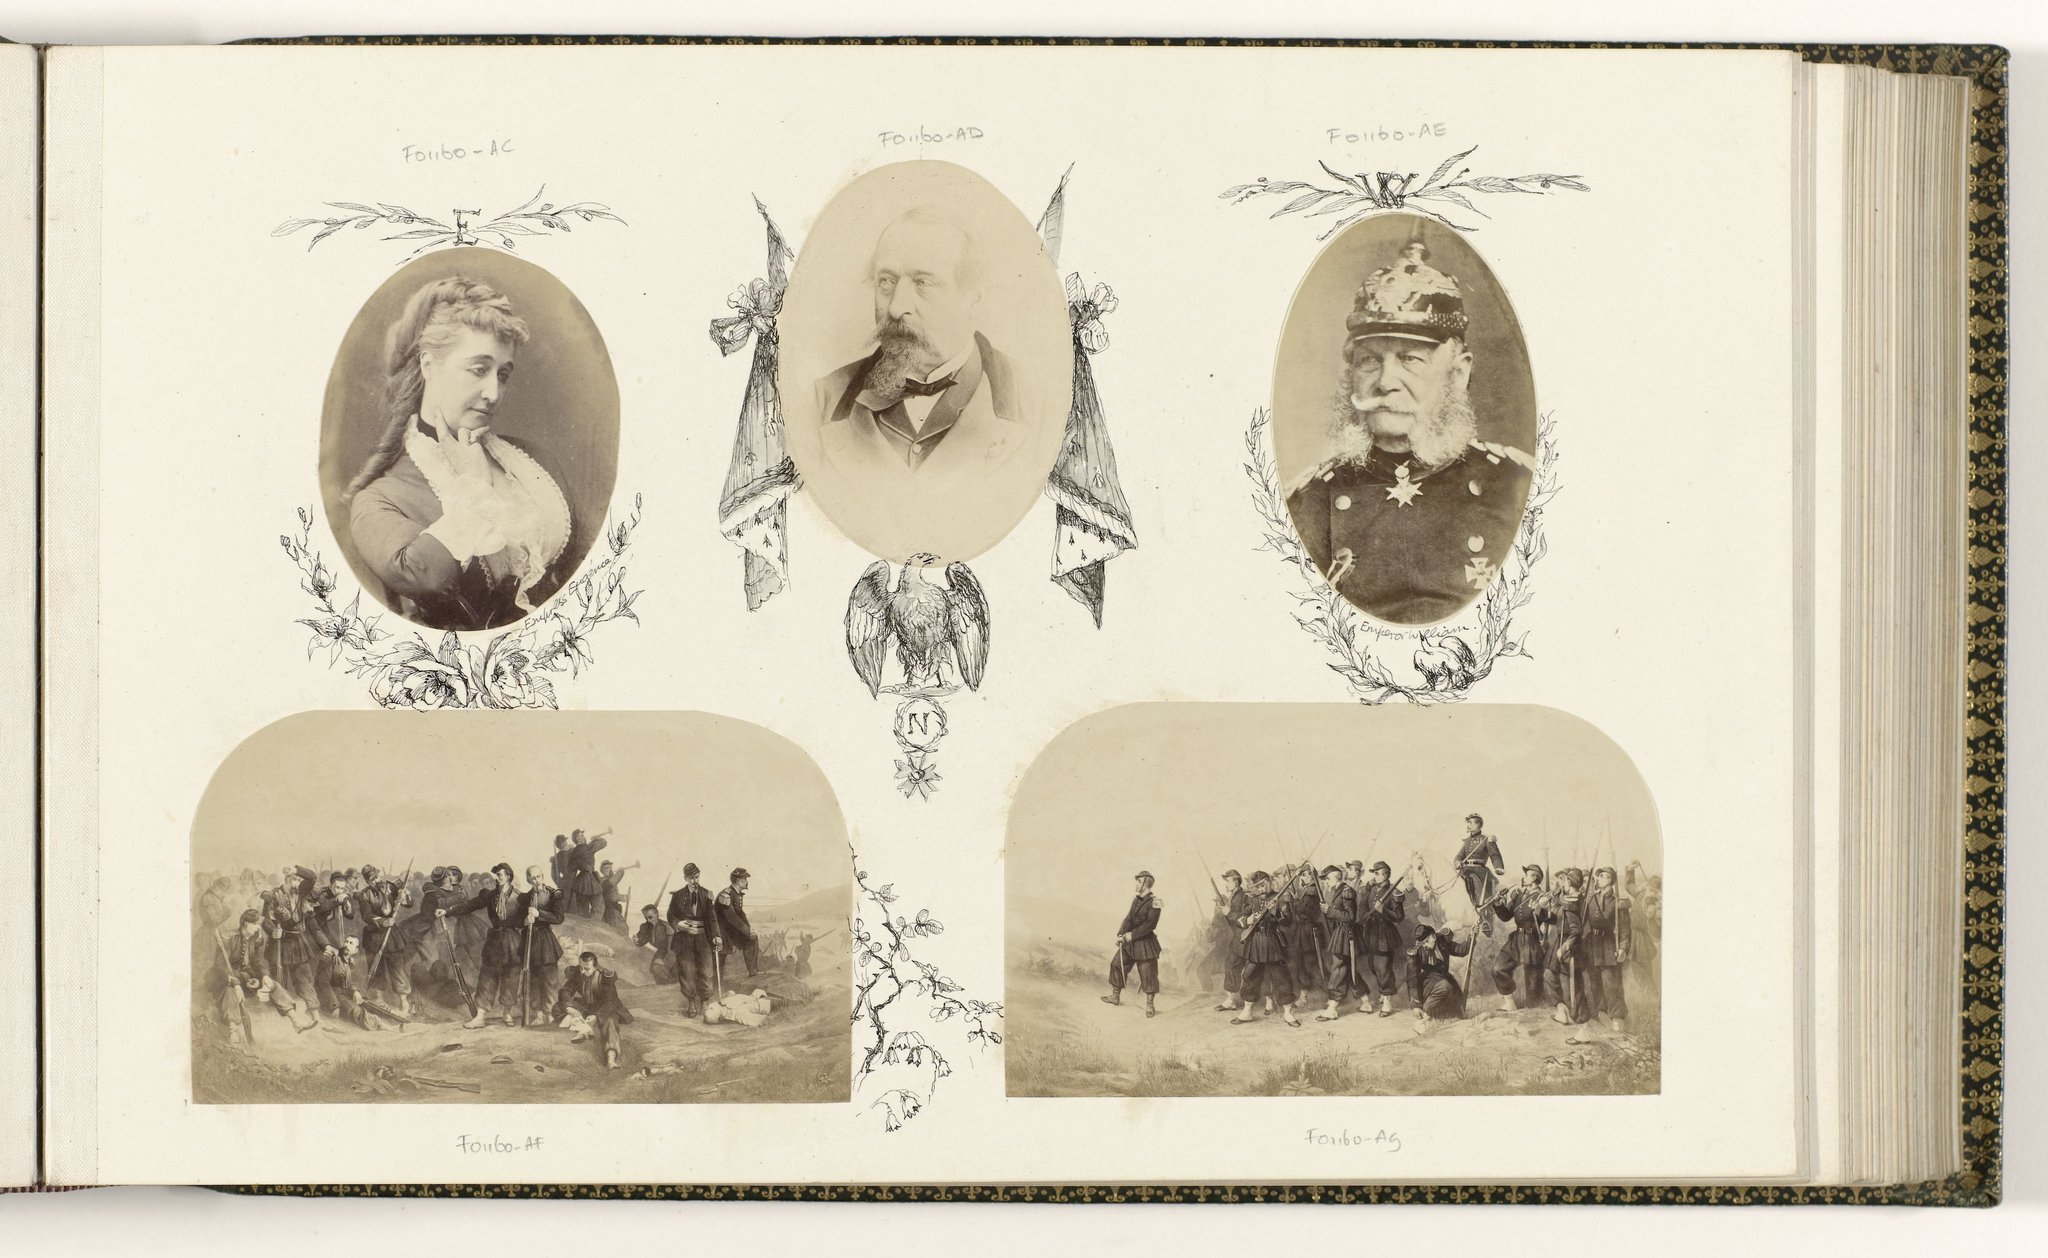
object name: photograph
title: Fotoreproductie van een tekening voorstellende de Frans-Duitse oorlog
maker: Anonymous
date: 1870-1875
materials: paper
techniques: albumen print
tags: drawing, battle